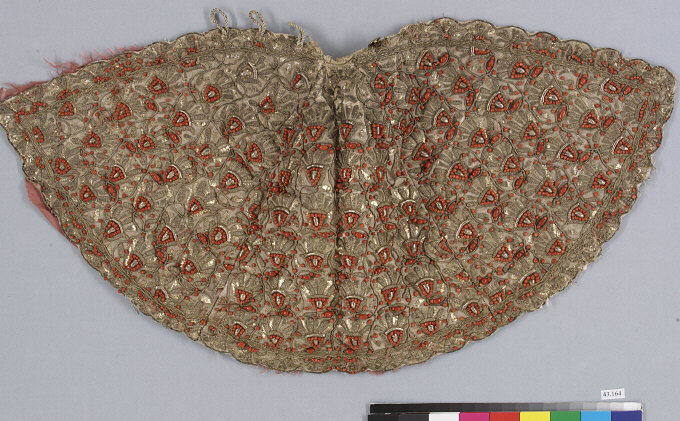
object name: statue robe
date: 1690-1720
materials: coral, metal thread